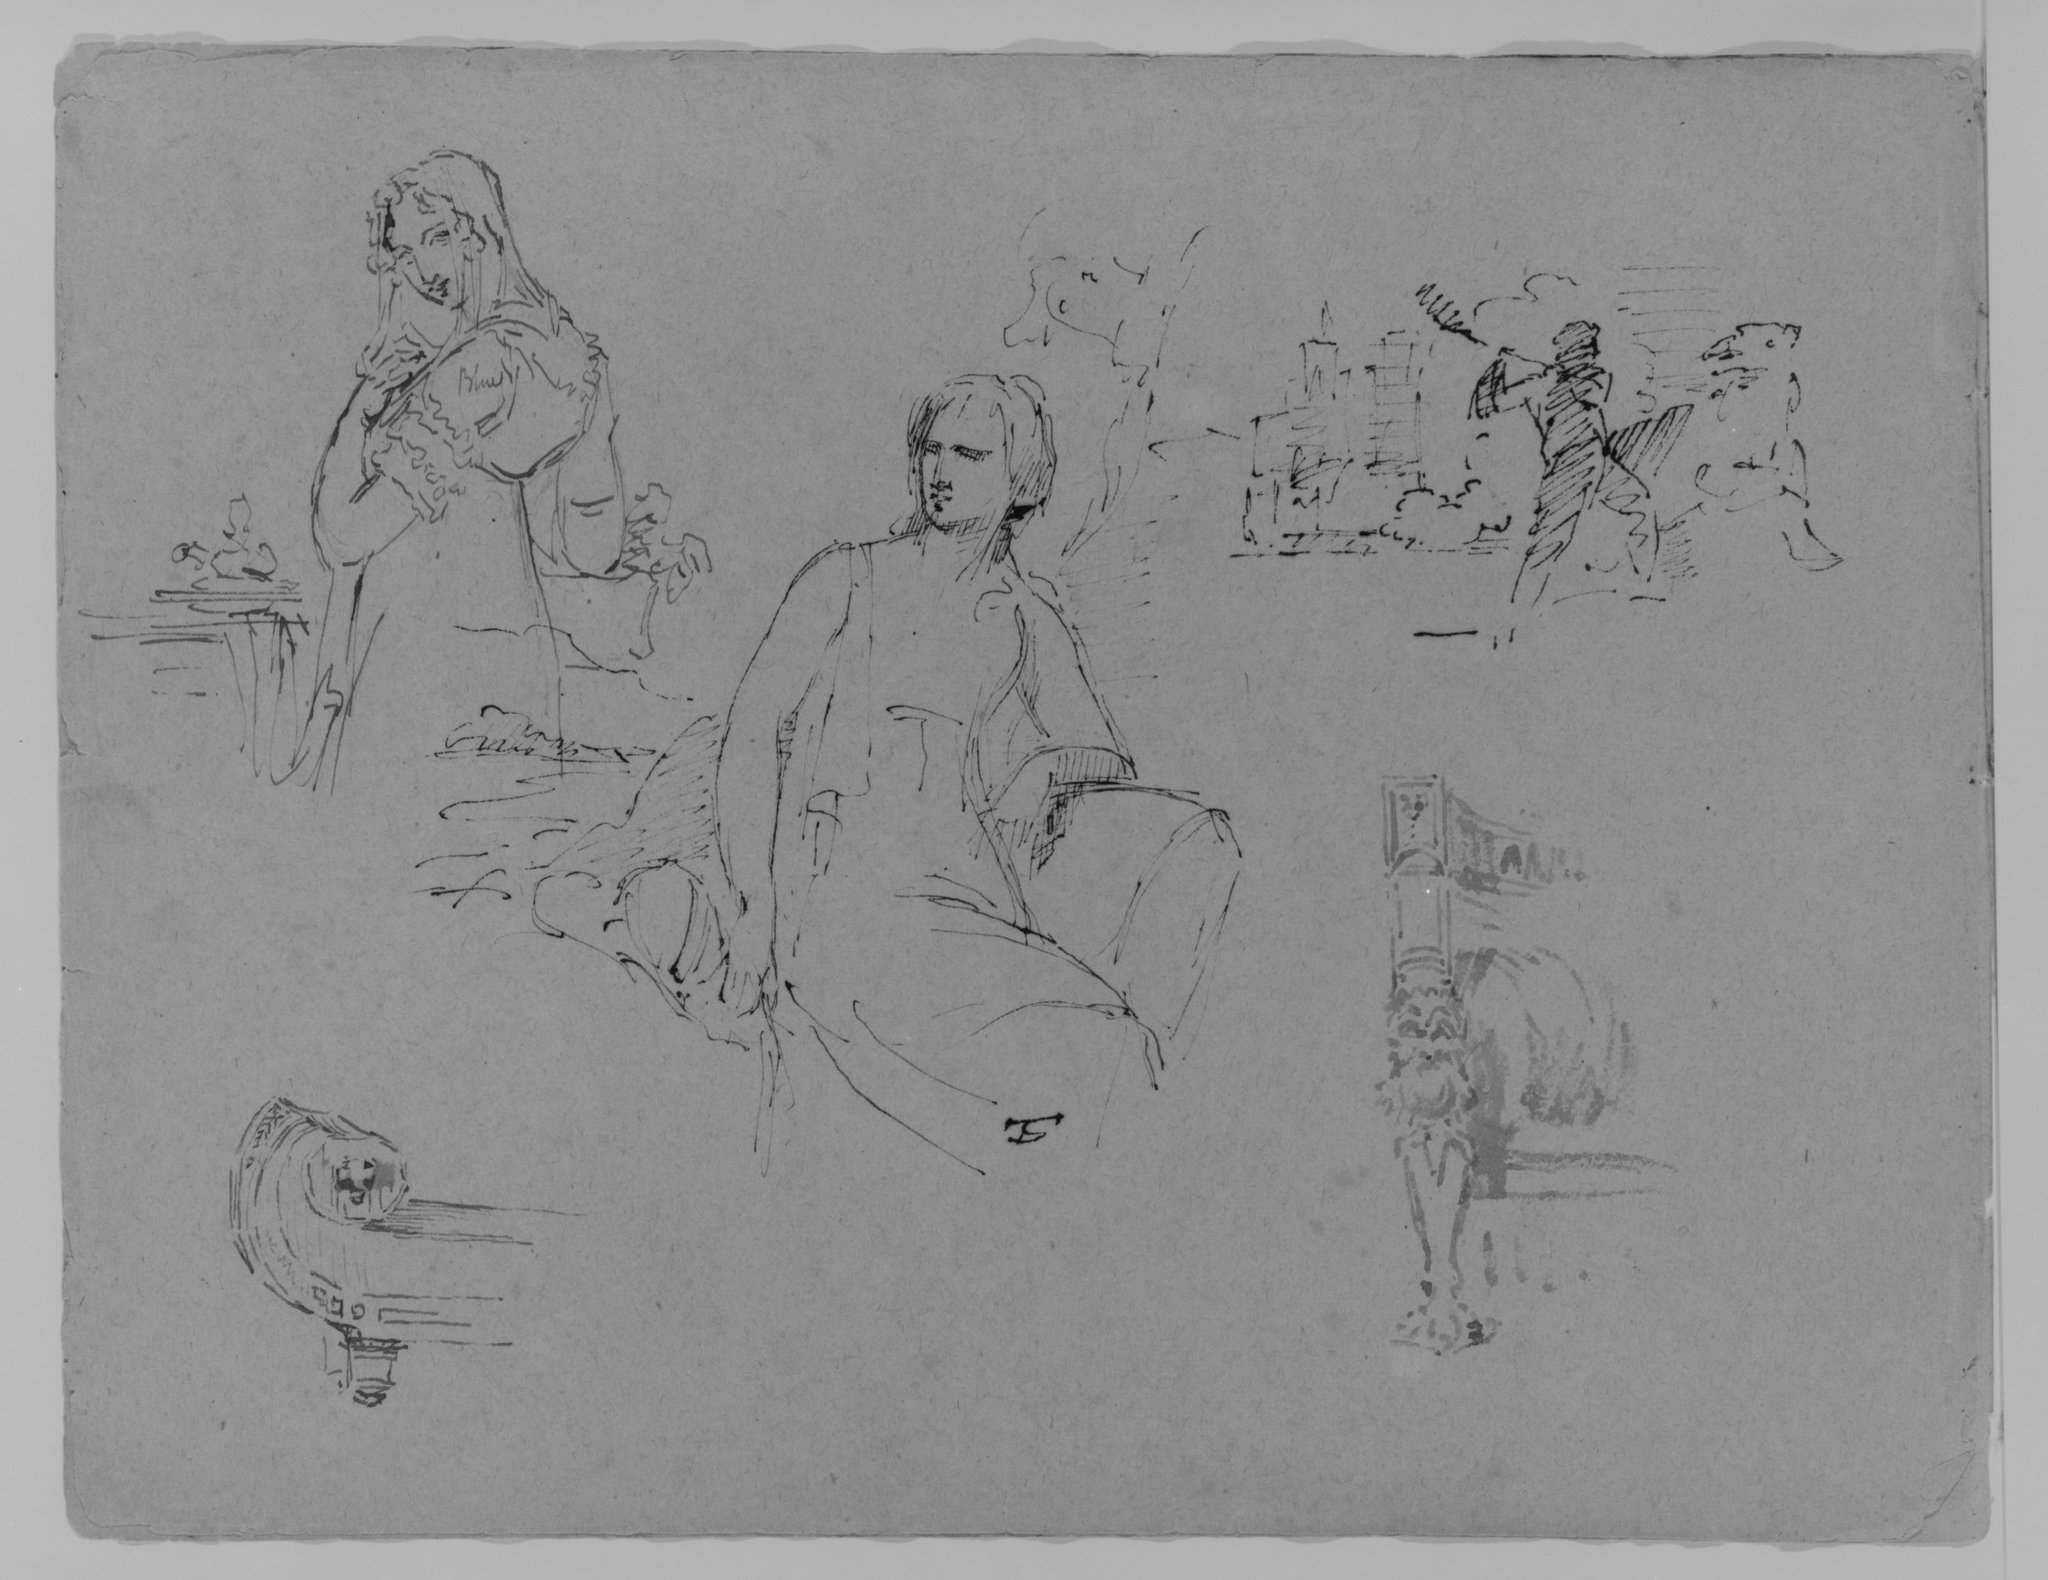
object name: drawing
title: (From Sketchbook)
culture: american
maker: thomas sully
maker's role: artist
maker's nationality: american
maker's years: 1783-1872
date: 1810-1820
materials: ink, paper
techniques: wash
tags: men,women